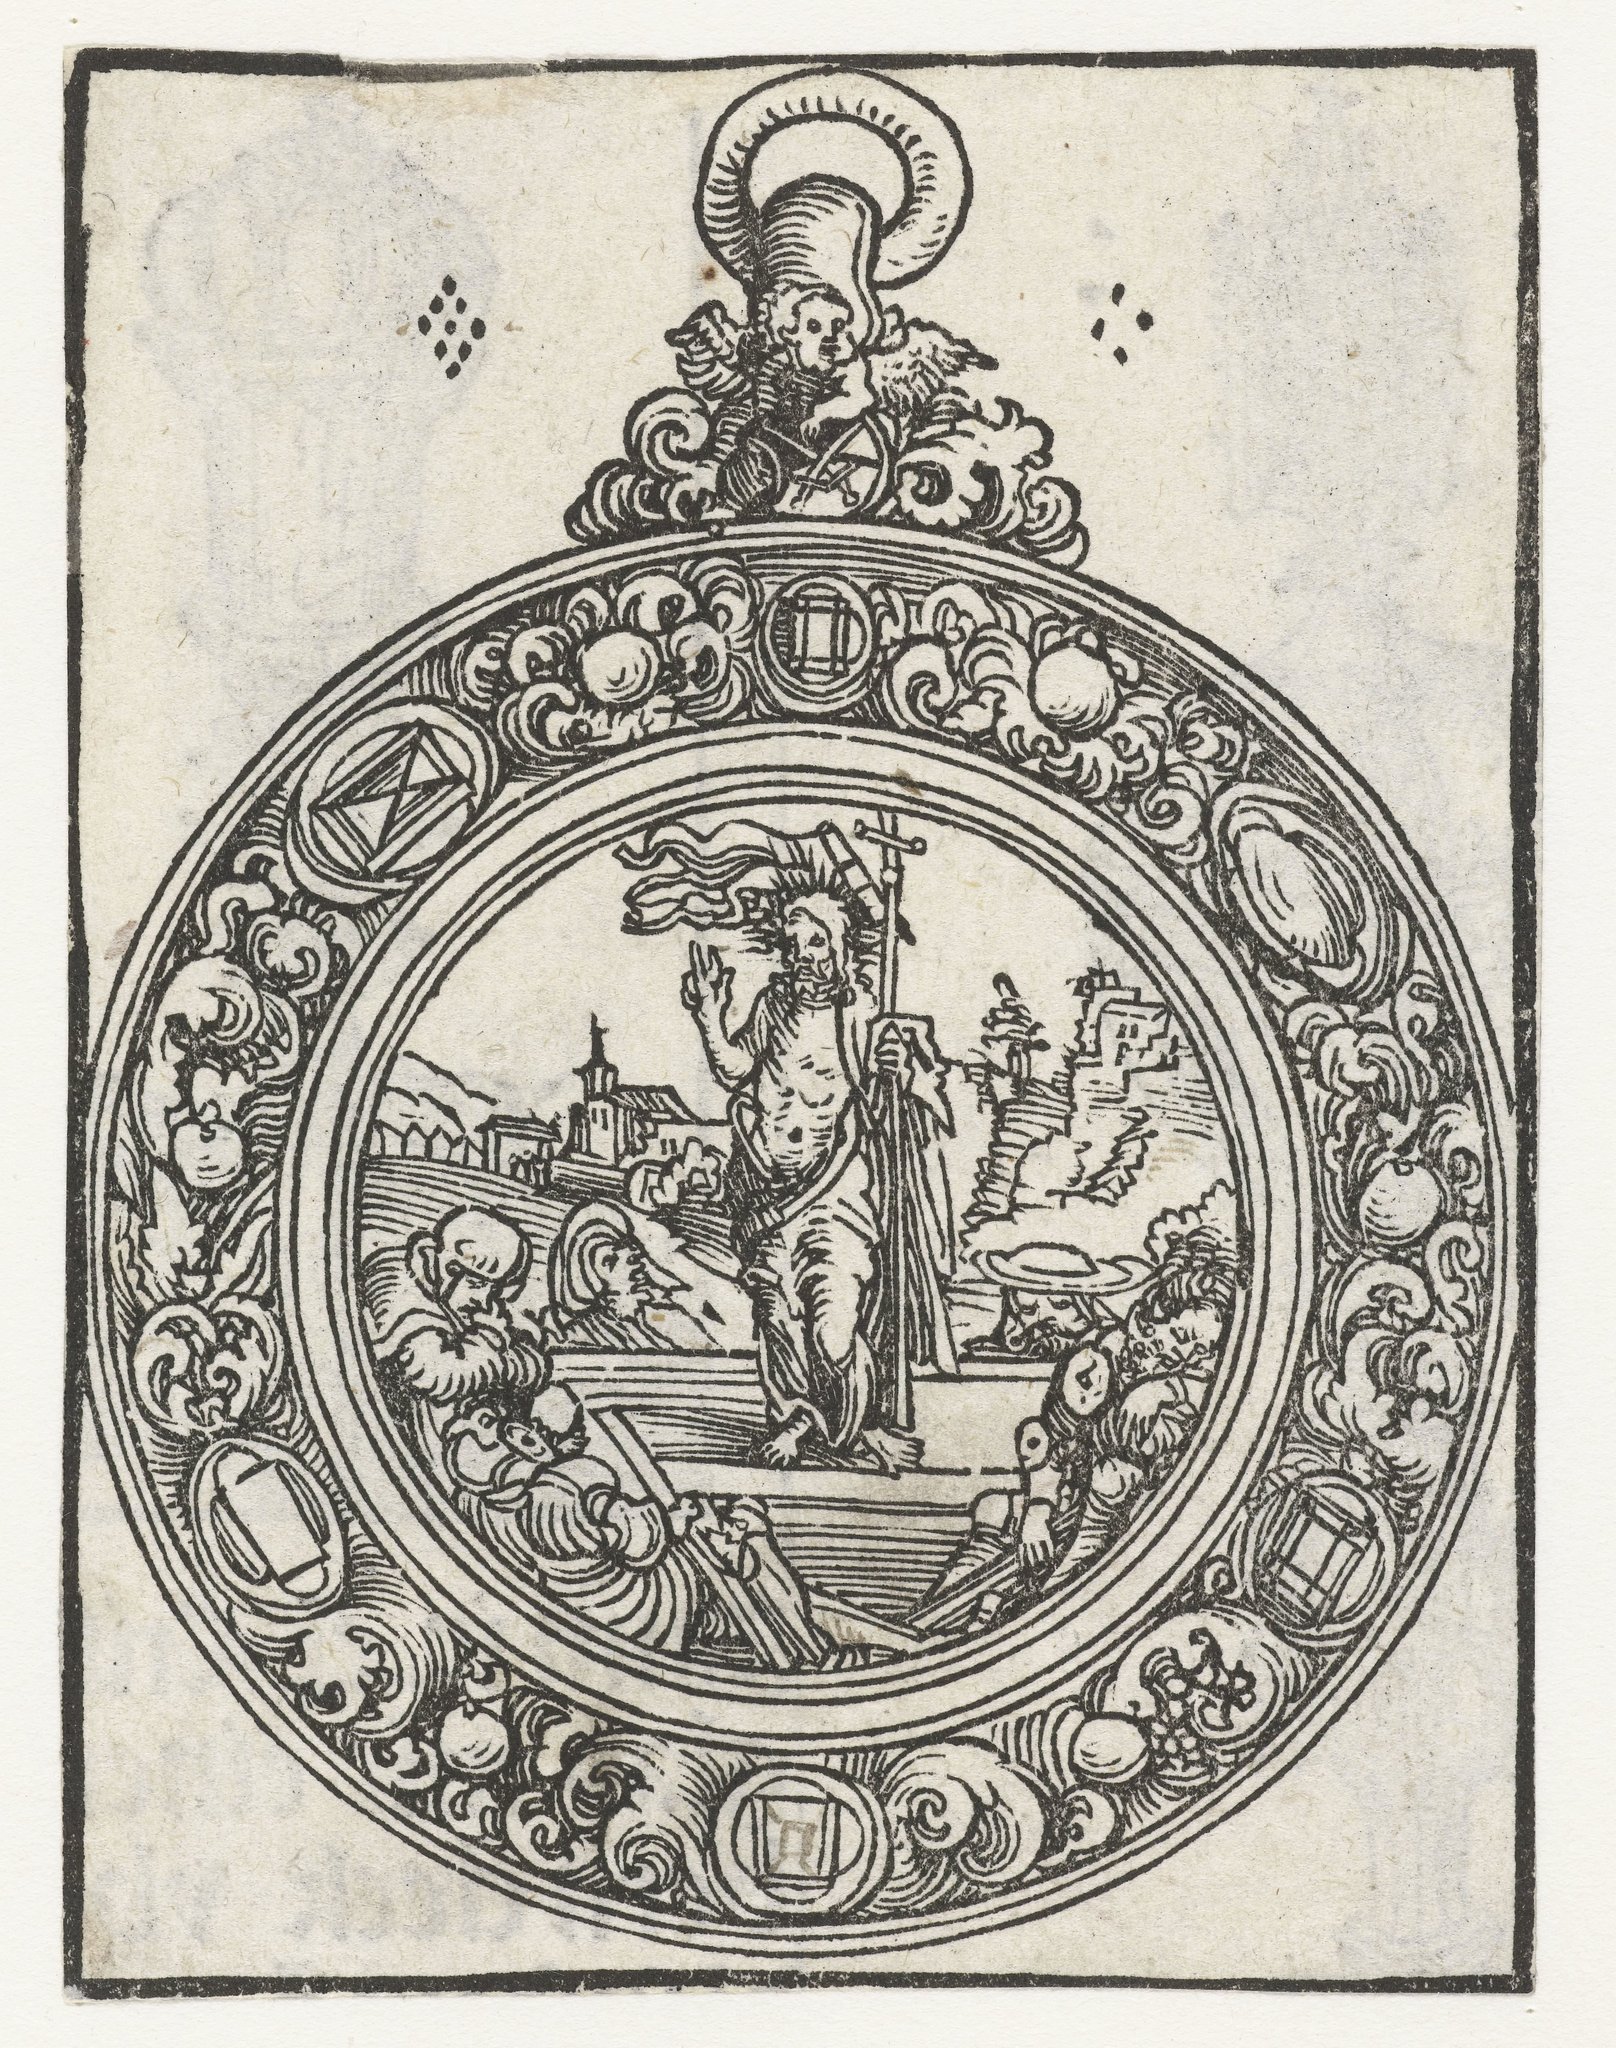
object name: print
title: Reliekhouder in vorm van medaillon met de opstanding van Christus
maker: lucas cranach (i)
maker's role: draughtsman, print maker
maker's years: 1472-1553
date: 1509-1549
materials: paper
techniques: woodcut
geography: wittenberg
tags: resurrection of christ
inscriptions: collector's mark: Lugt 240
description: Reliekhouder in de vorm van een medaillon met de opstanding van Christus. De rand is versierd met ornamenten en edelstenen. Op de bovenkant van het voorwerp zit een oog. Op het verso van deze boekillustratie staan fragmenten van afbeeldingen van twee reliekhouders en een fragment van een onderschrift in Duitse tekst bij dit liturgisch vaatwerk.